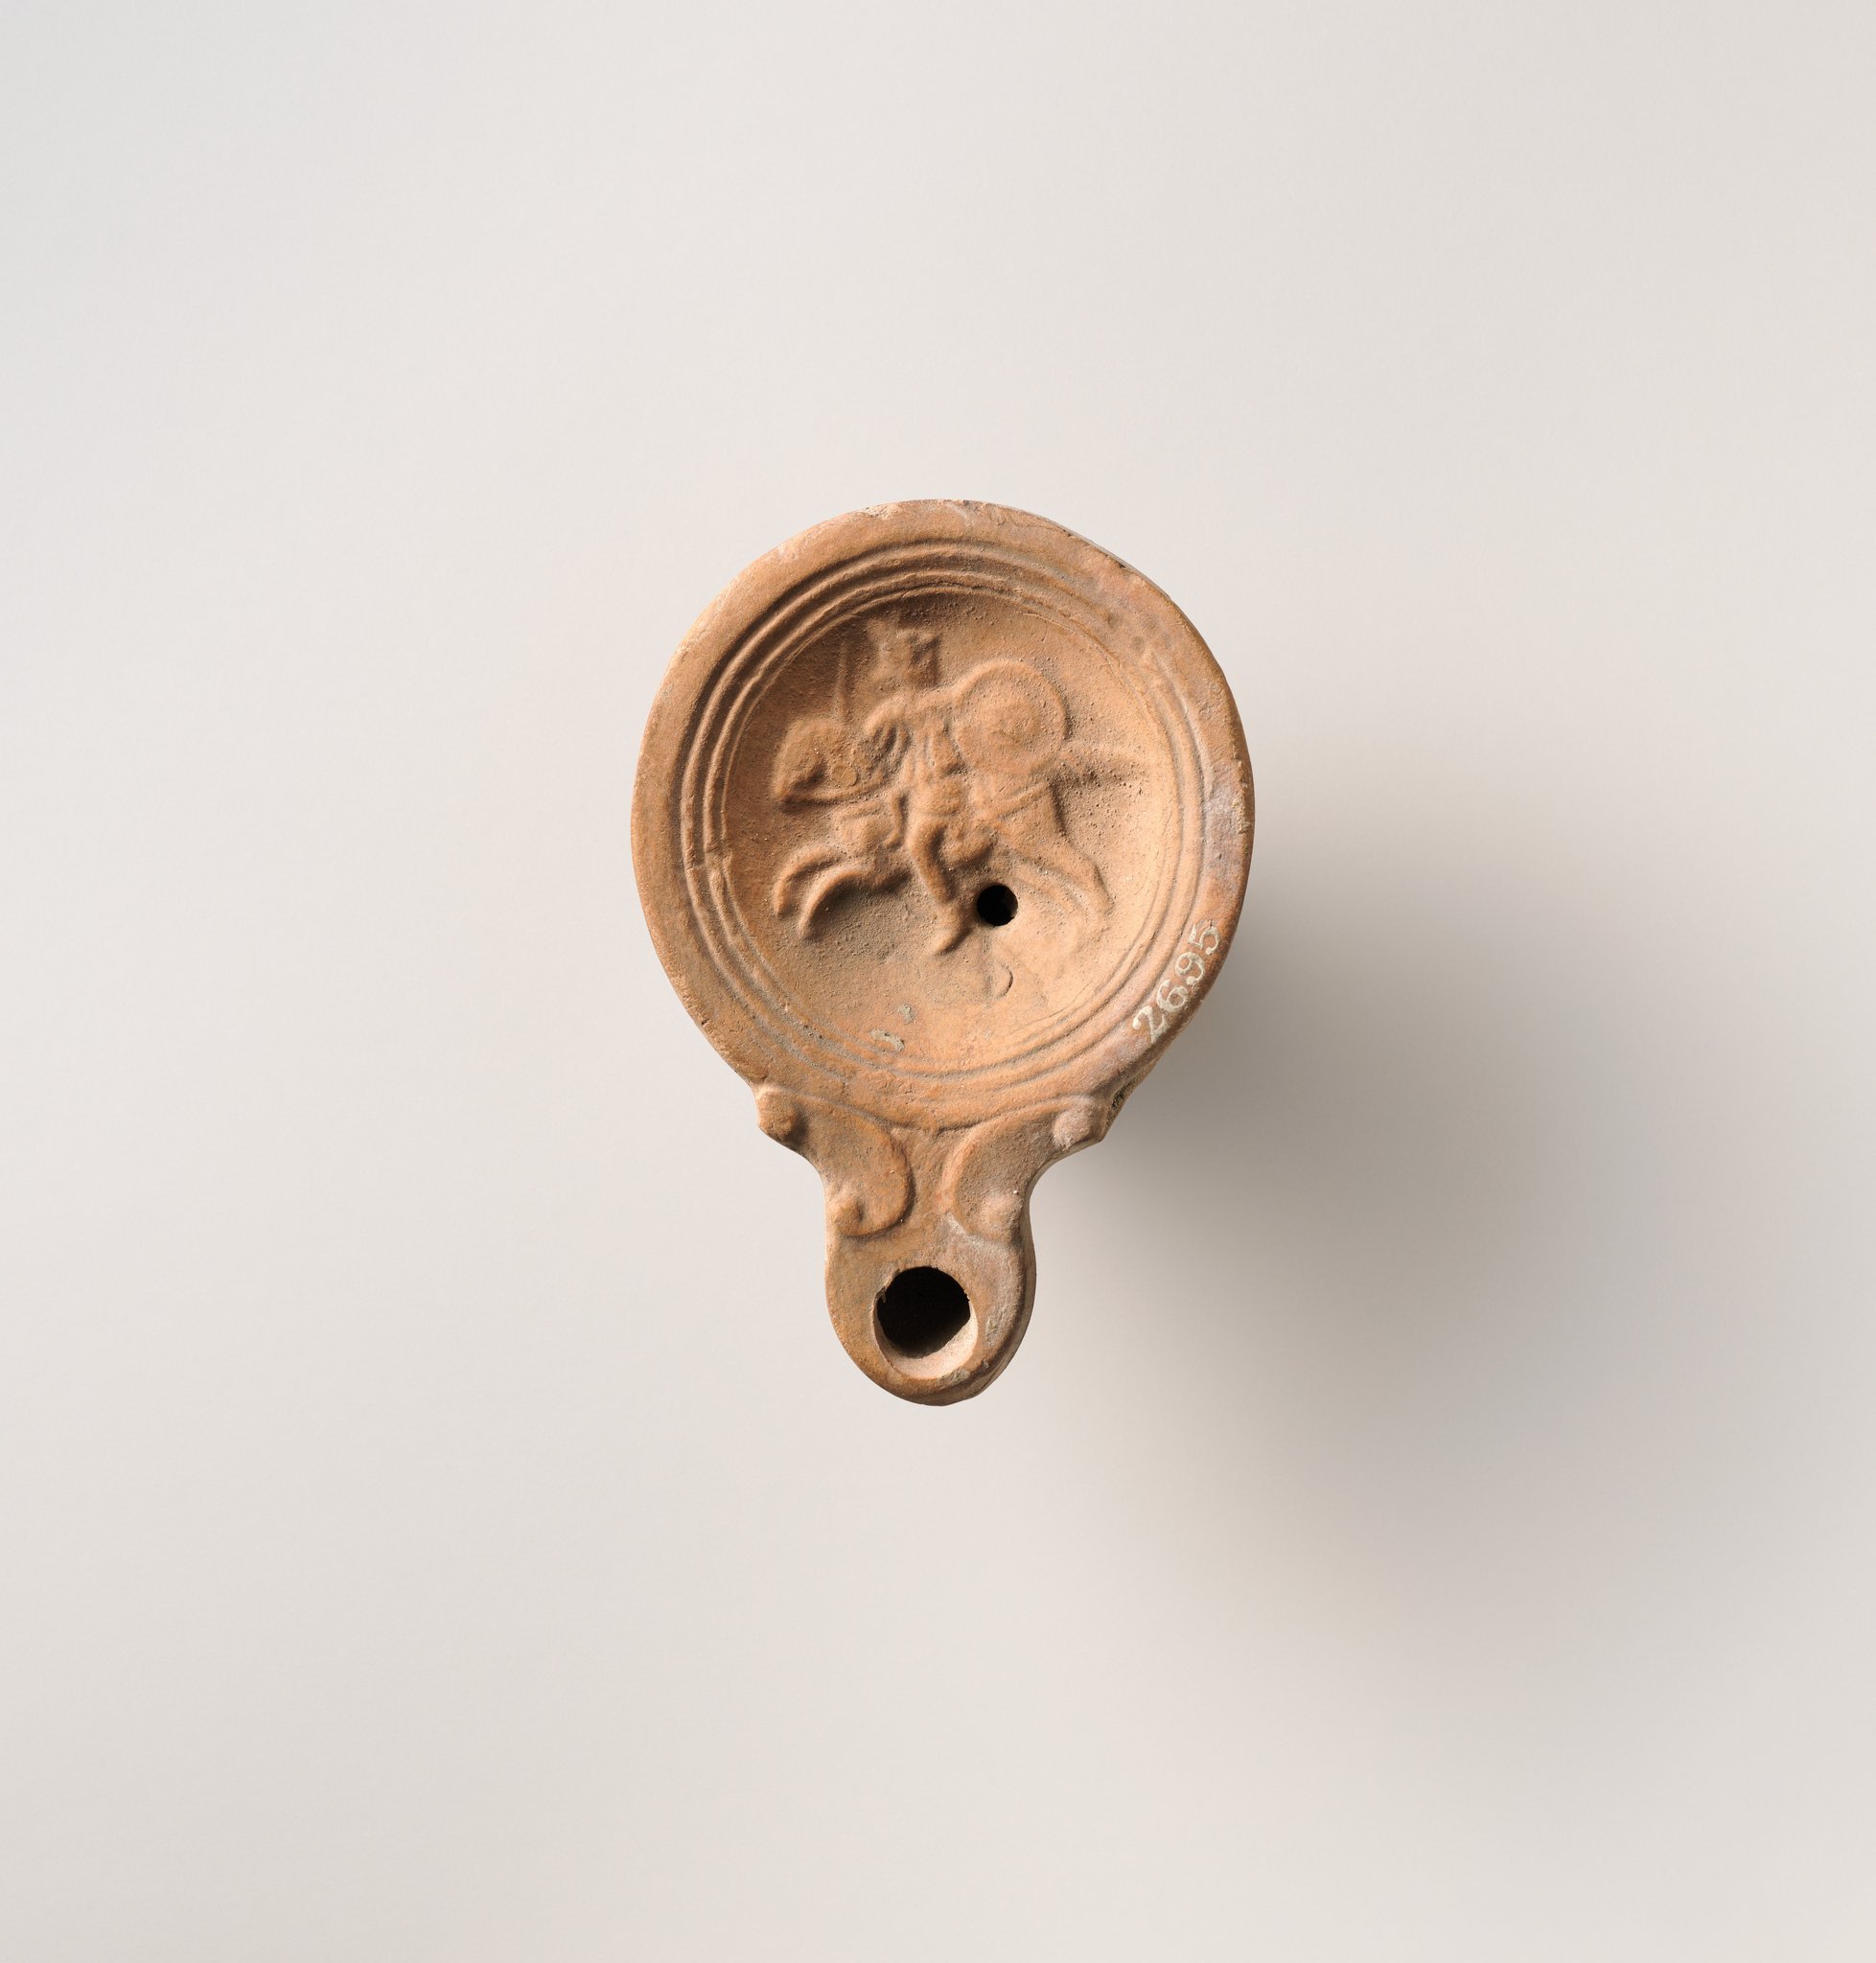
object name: lamp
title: Terracotta oil lamp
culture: roman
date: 40-100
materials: terracotta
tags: men,horses